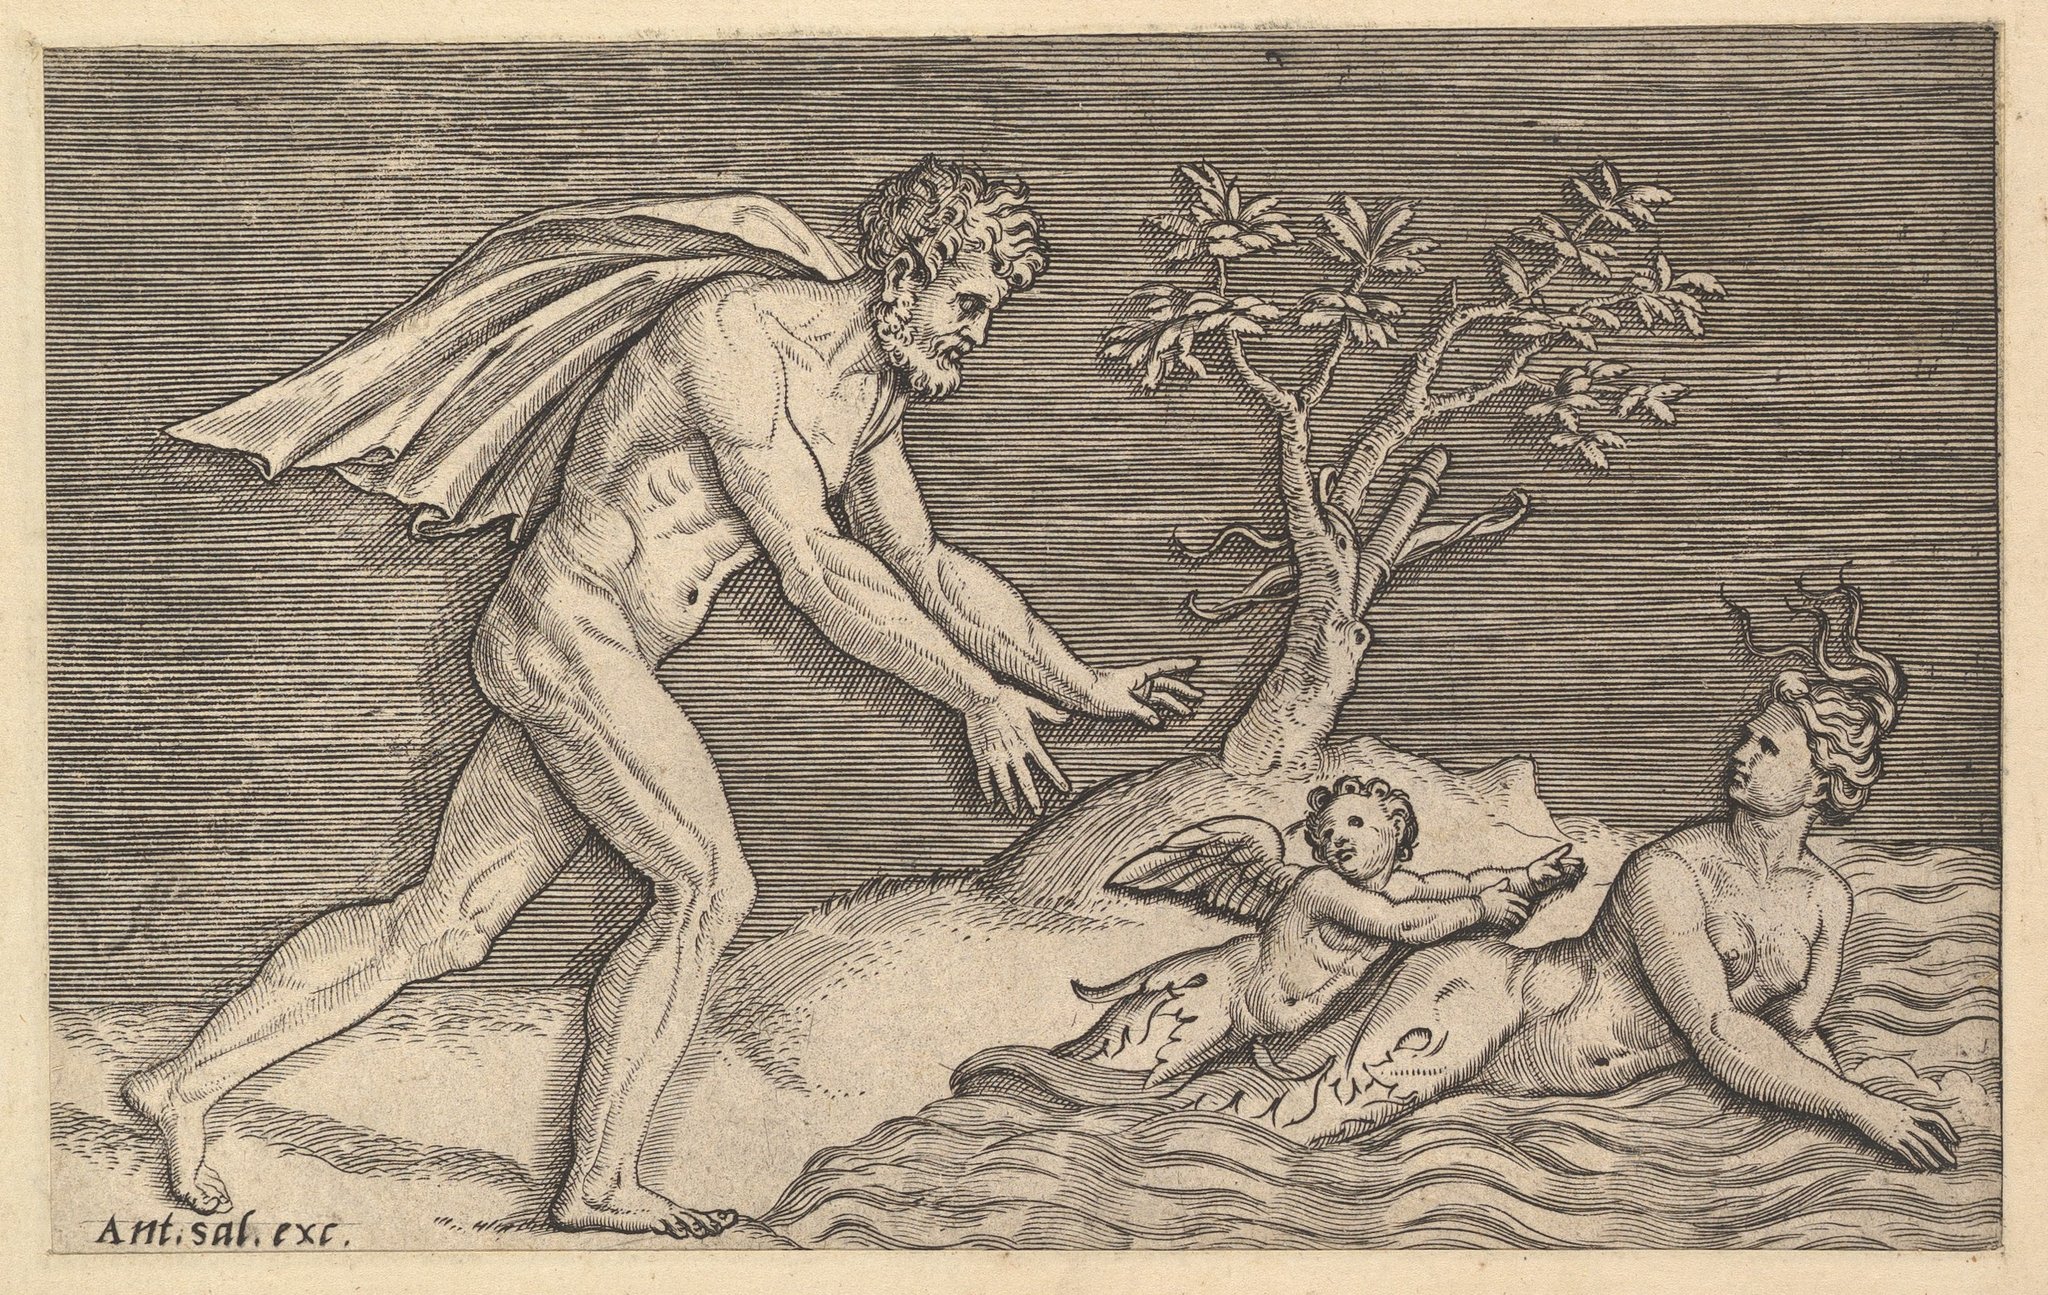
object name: print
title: Naked Man Pursuing a Naiad, from "Speculum Romanae Magnificentiae"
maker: marco dente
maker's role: artist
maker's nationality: italian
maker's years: 1515-1527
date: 1515-1527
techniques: engraving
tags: male nudes